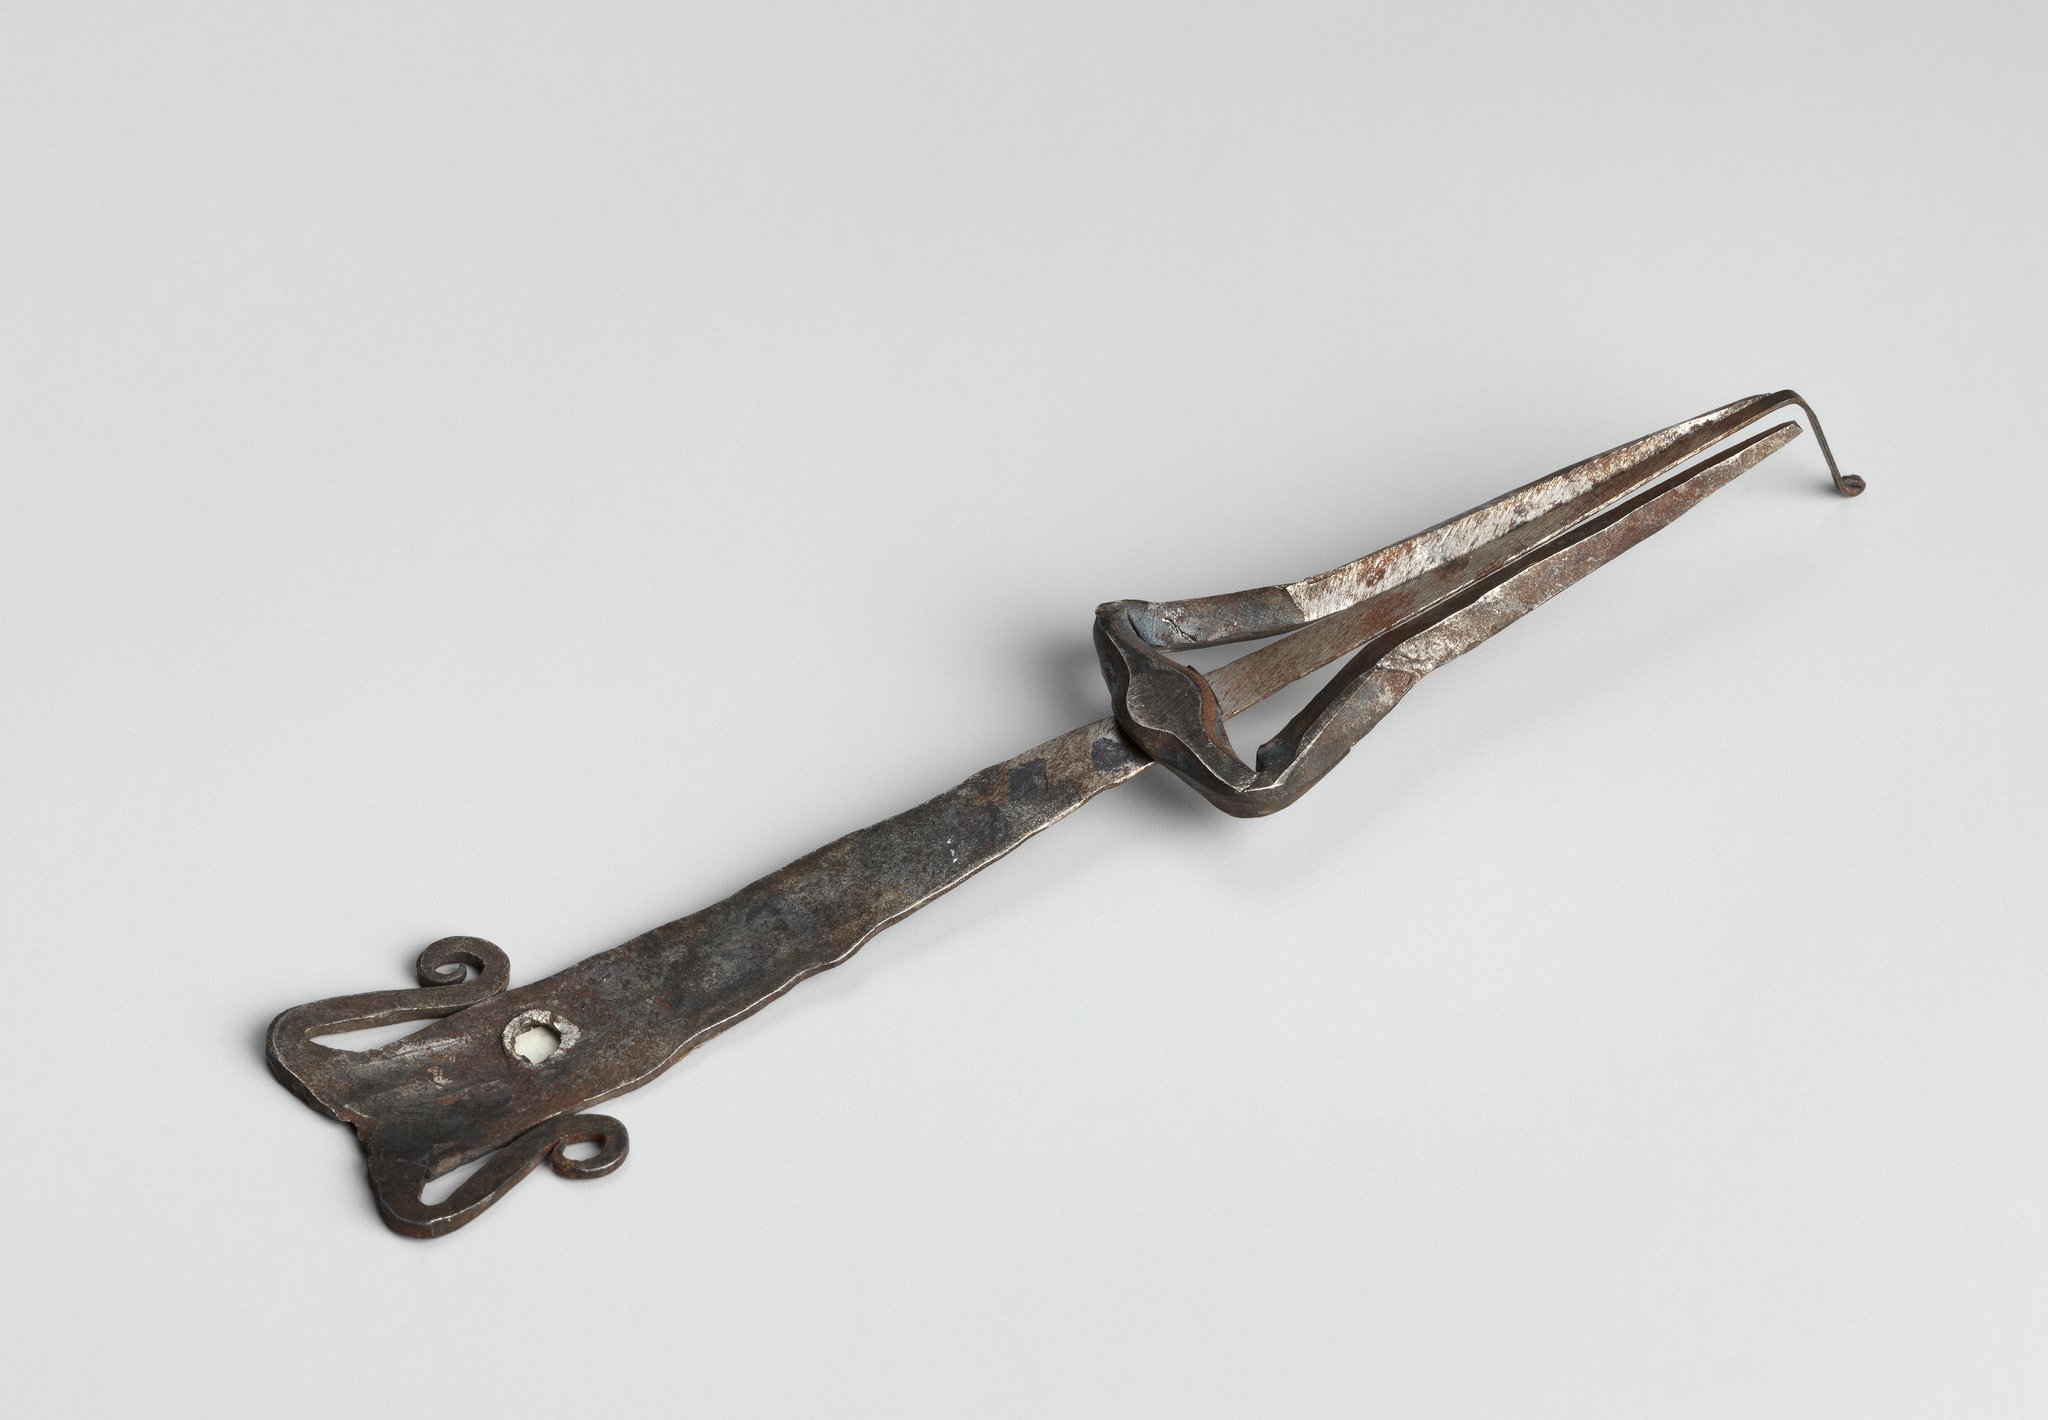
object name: chang jaw harp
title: Chang (jaw harp)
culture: afghan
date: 1934-1966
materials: iron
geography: afghanistan